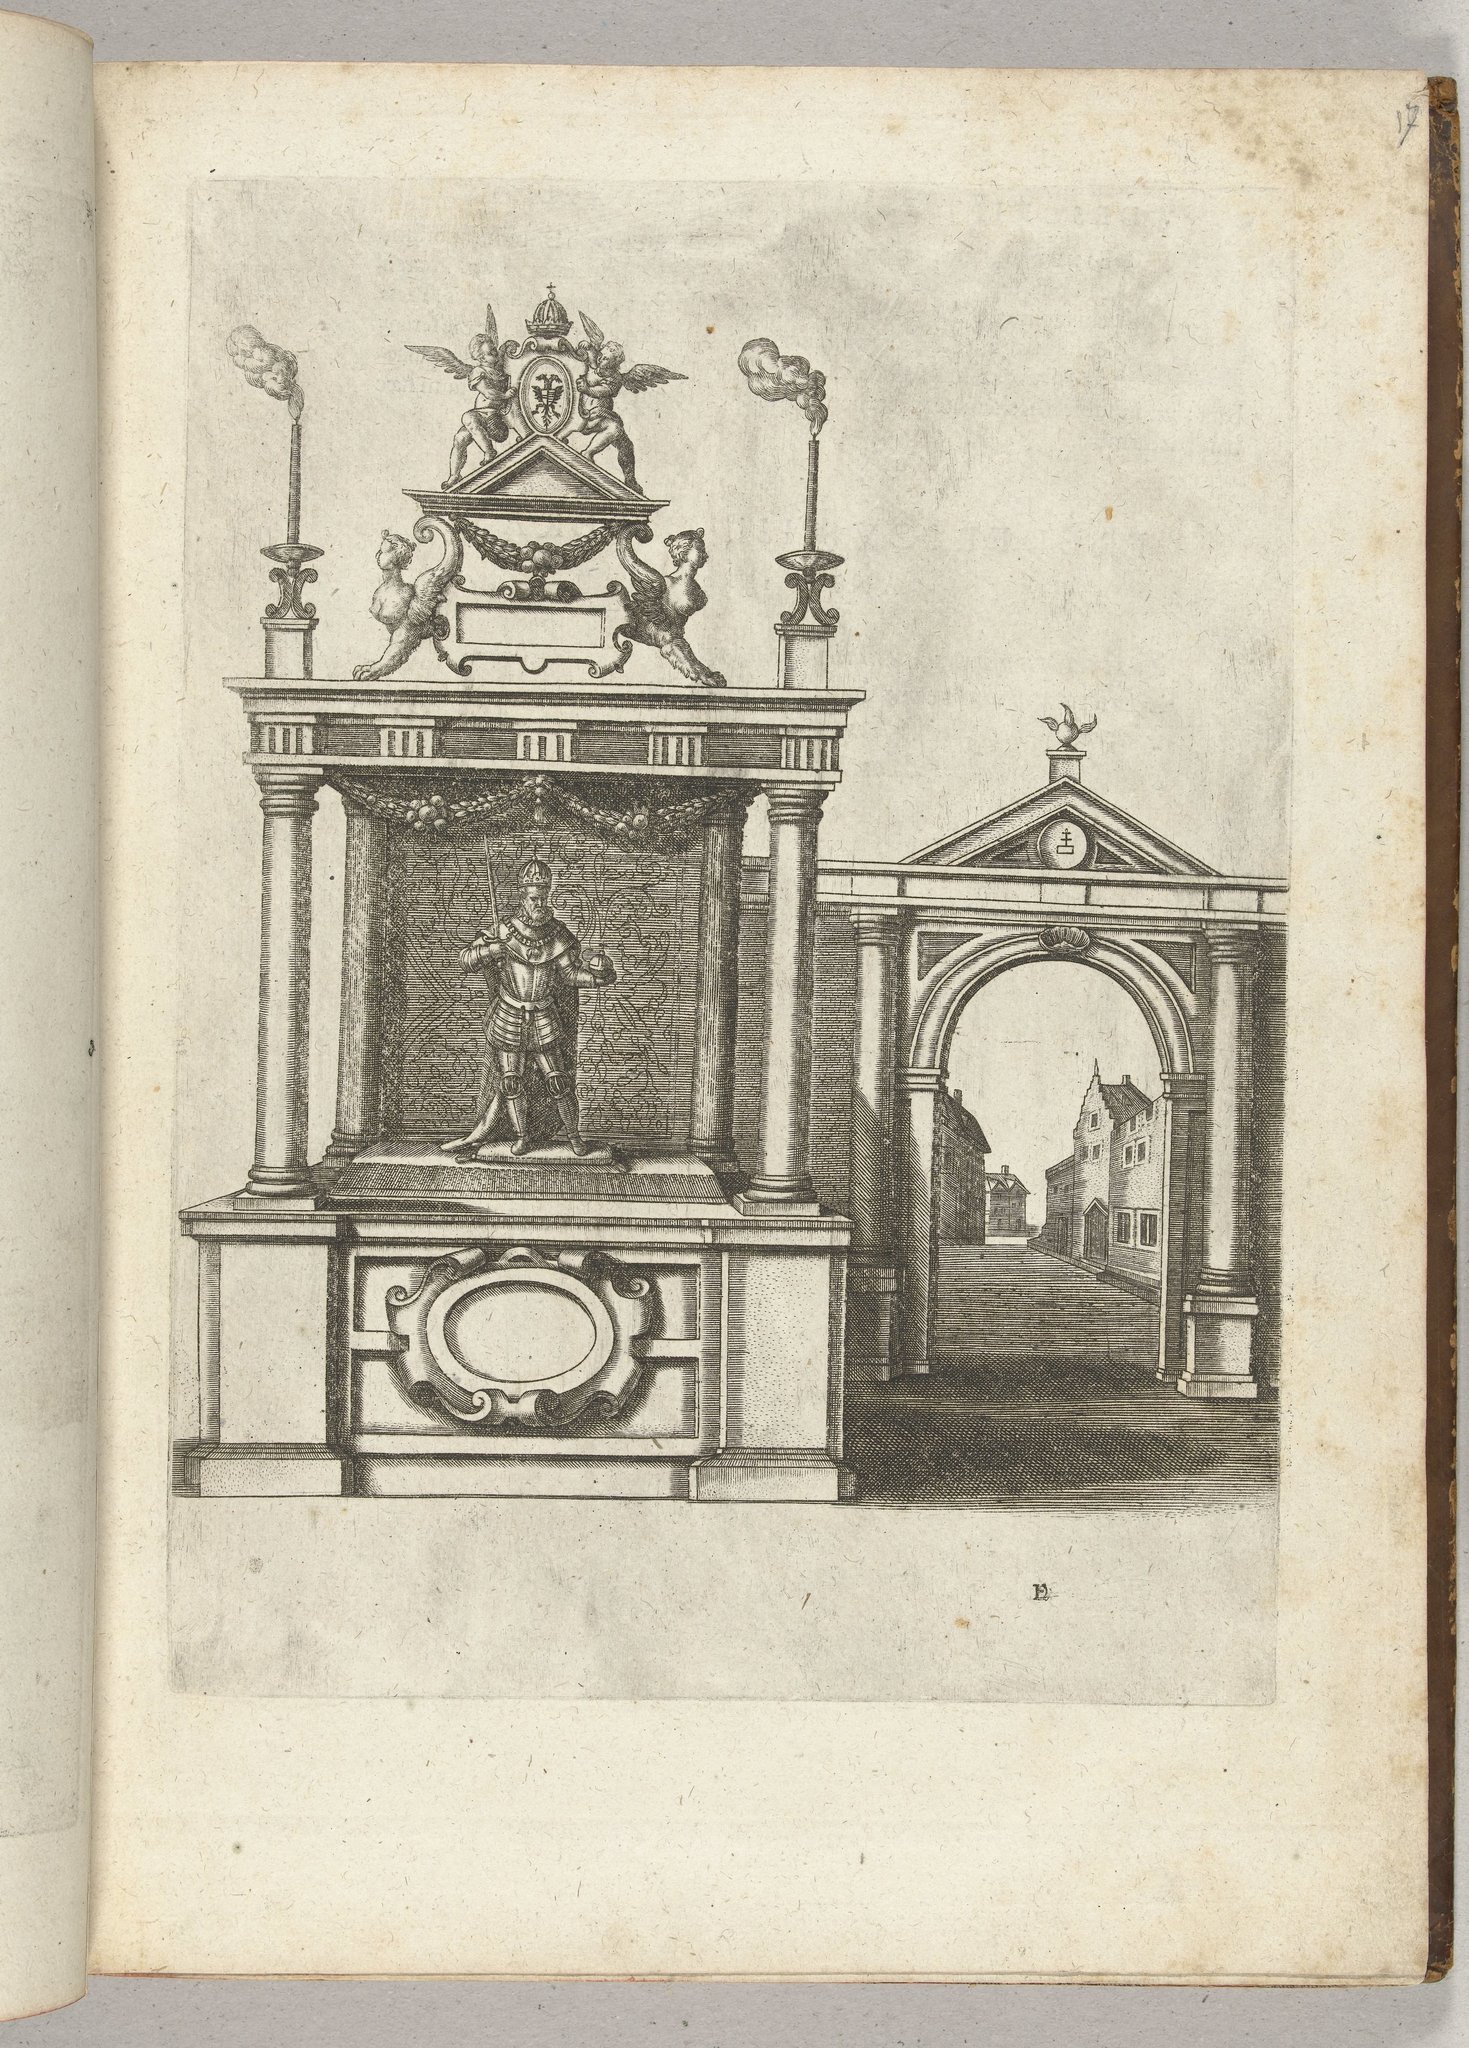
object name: print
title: Toneel met keizer Albrecht II, 1594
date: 1594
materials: paper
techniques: engraving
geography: southern netherlands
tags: vienna, brussels, triumphal entry and public reception, pageant, 'entrée solennelle', 'joyeuse entrée'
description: Illustratie in: Descriptio et explicatio pegmatvm, arcvvm et spectacvlorvm qvae Brvxellae Brabant : pridie cal: Febr. Ao 1594 exhibita fvere, svb ingressvm Sereniss : Principis Ernesti, Dei Gratia Archidvcis Avstriae ... pro Philippo II. Hispaniarvm Monarcha, Belgicae ditionis Gvbernatore, Johannes Mommaert, Brussel 1594, [plaat 7]. In de collectie van de Rijksmuseum Research Library, signatuur: 325 A 9. Niet in Frederik Muller; door het RPK toegevoegd nummer.